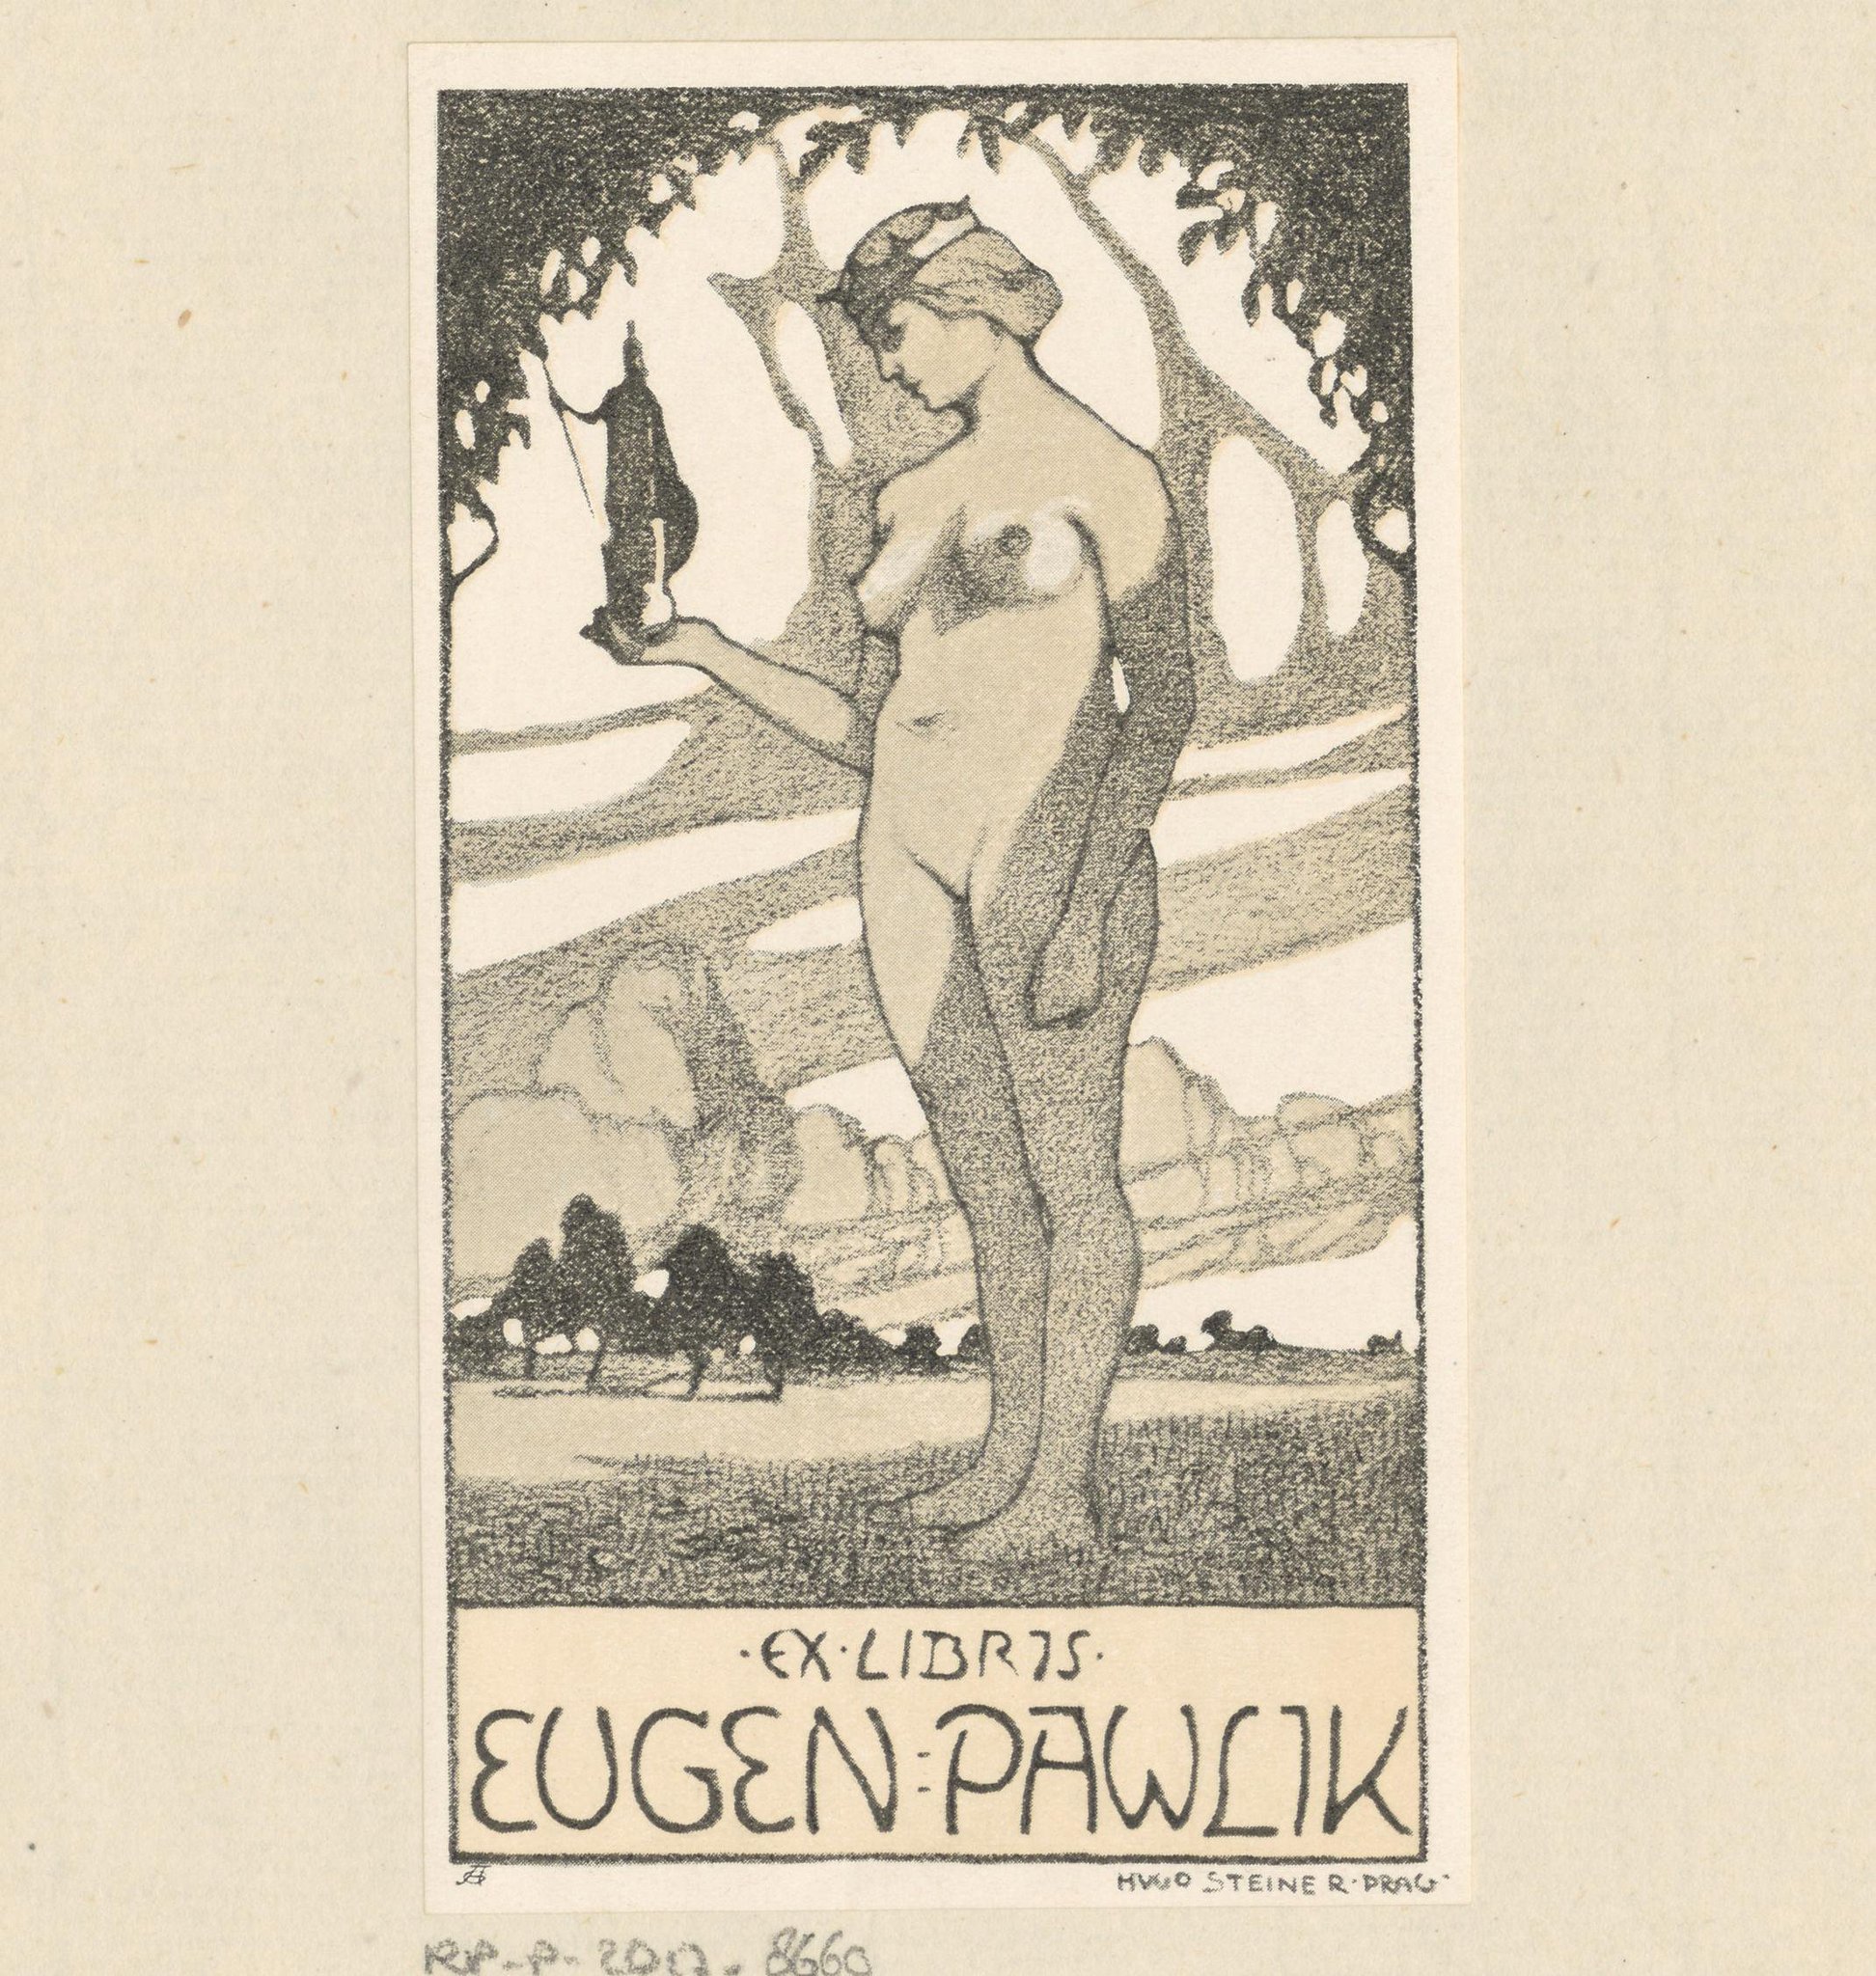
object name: bookplate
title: Ex libris van Eugen Pawlik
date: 1890-1913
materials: paper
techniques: autotype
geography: czech republic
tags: landscapes, (story of) minerva (pallas, athena), woman (showing herself) undressed, quasi-nude